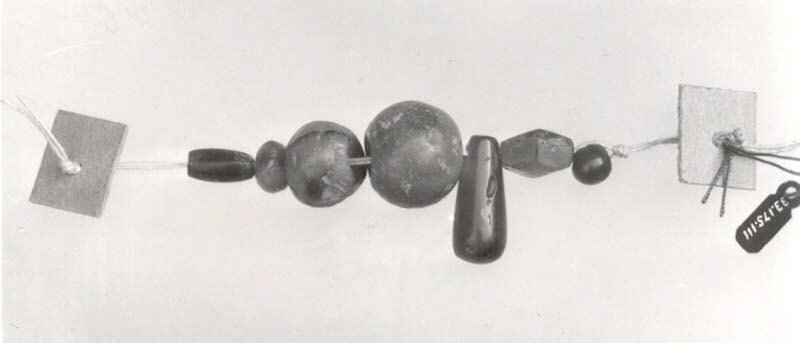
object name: necklace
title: Bead necklace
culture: sasanian or islamic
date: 501-800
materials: gemstone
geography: iran